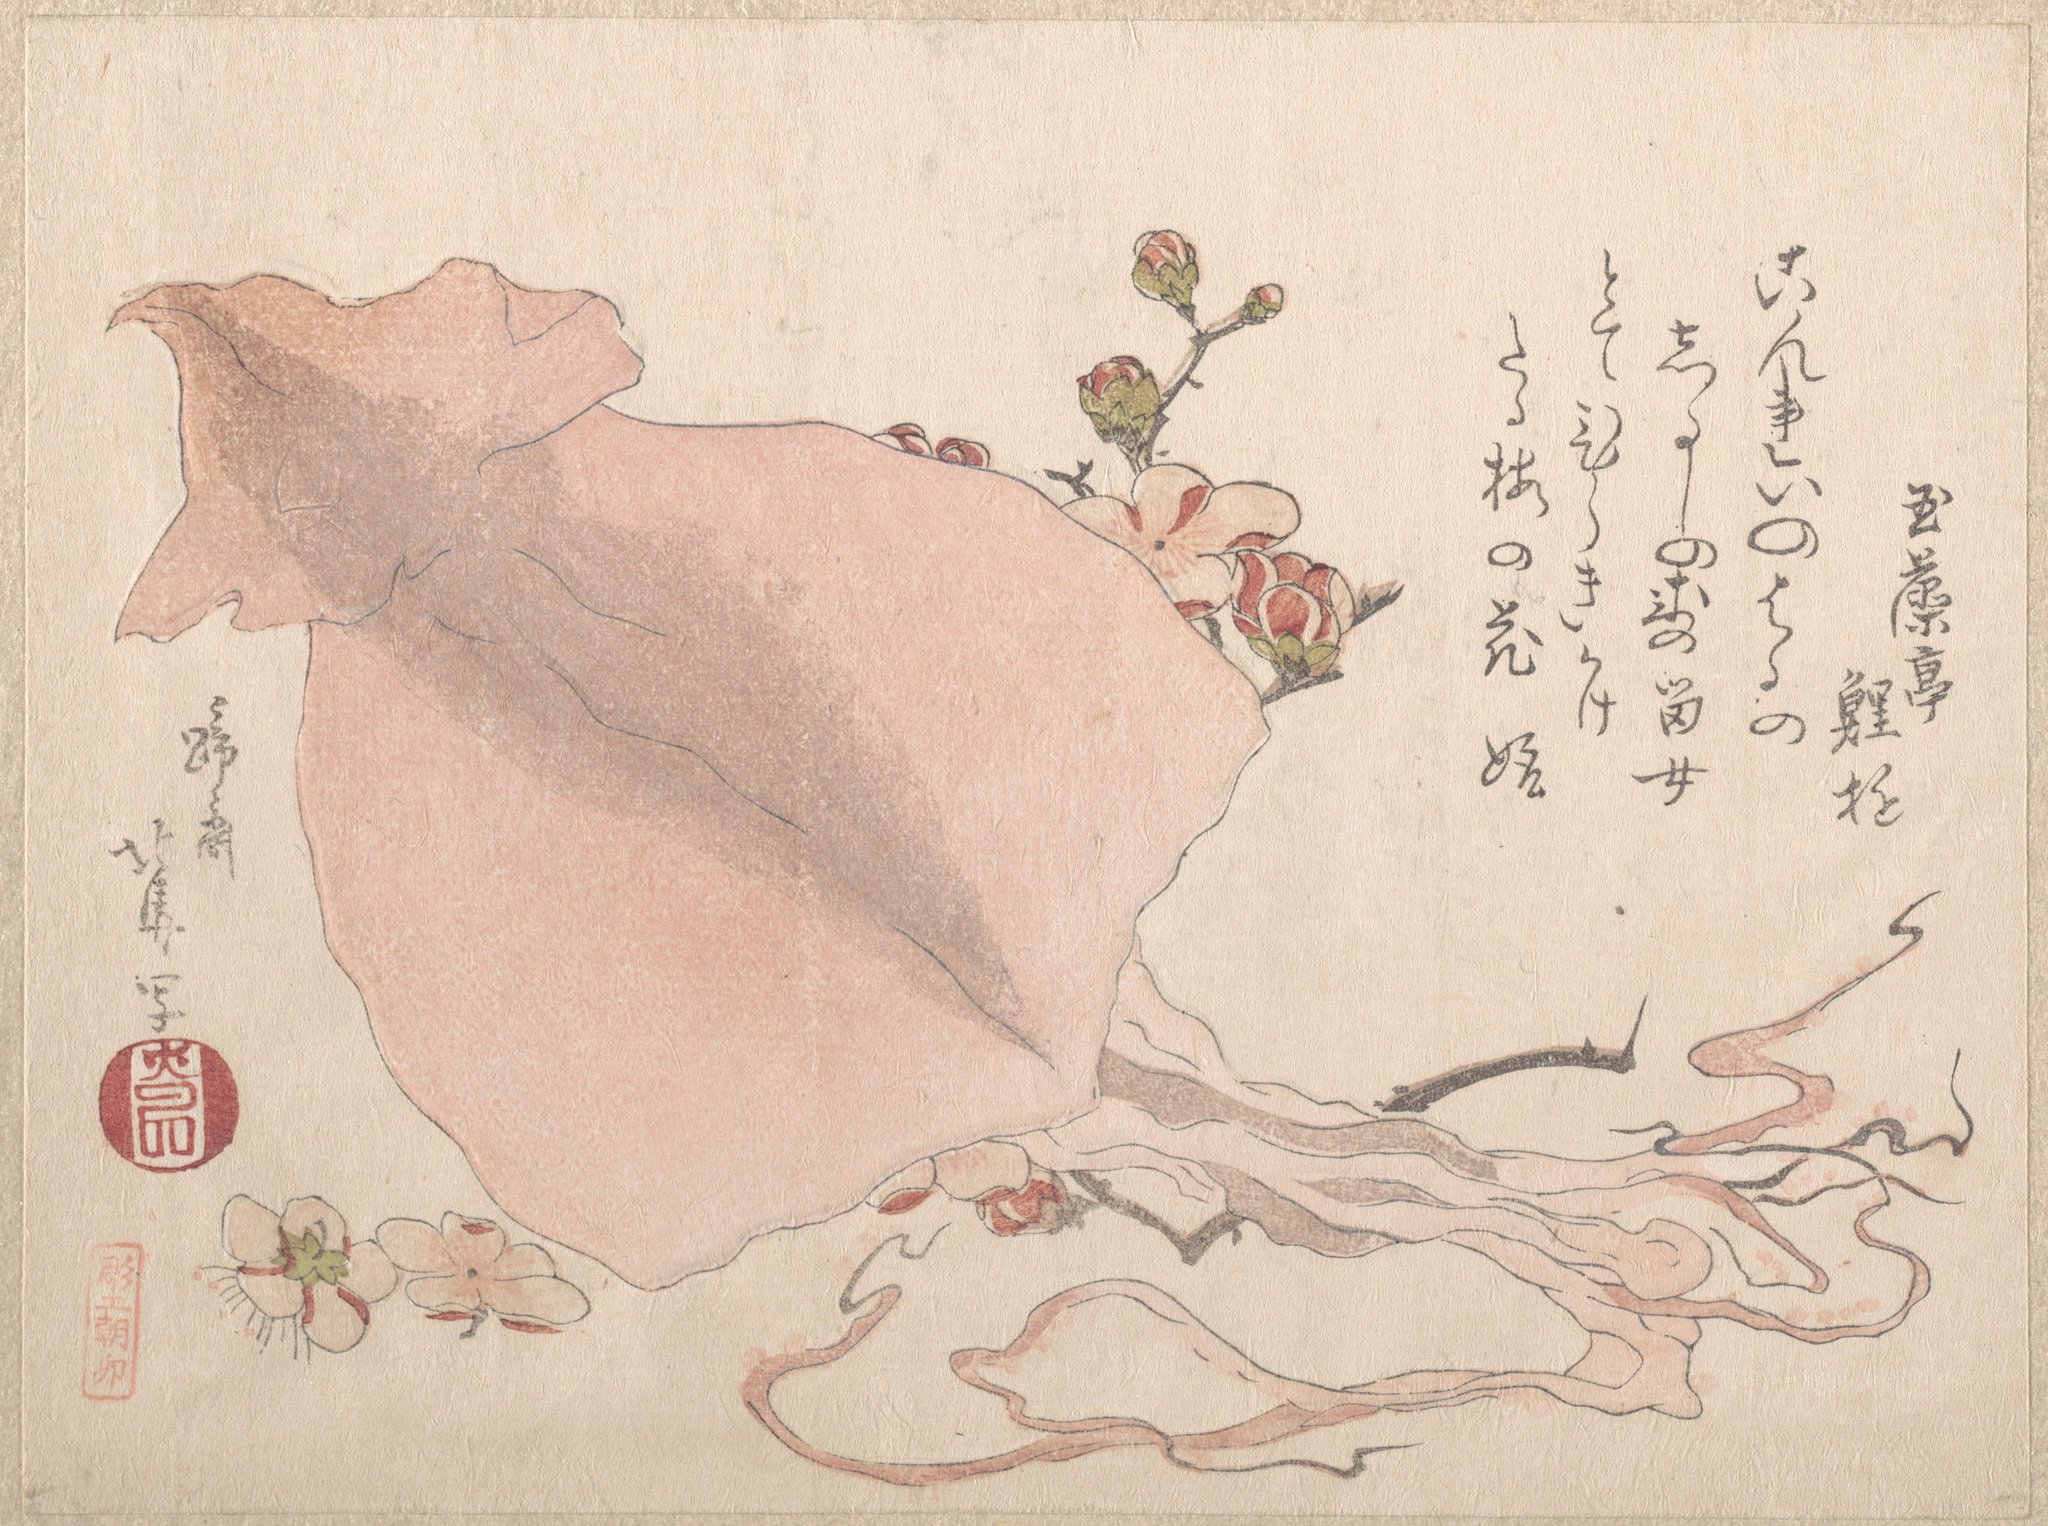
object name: woodblock print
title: Dried Cuttle-Fish and Plum Blossoms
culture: japanese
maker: teisai hokuba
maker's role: artist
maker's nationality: japanese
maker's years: 1771-1844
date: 1801-1833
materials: ink, paper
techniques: surimono, woodblock print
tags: fish,flowers